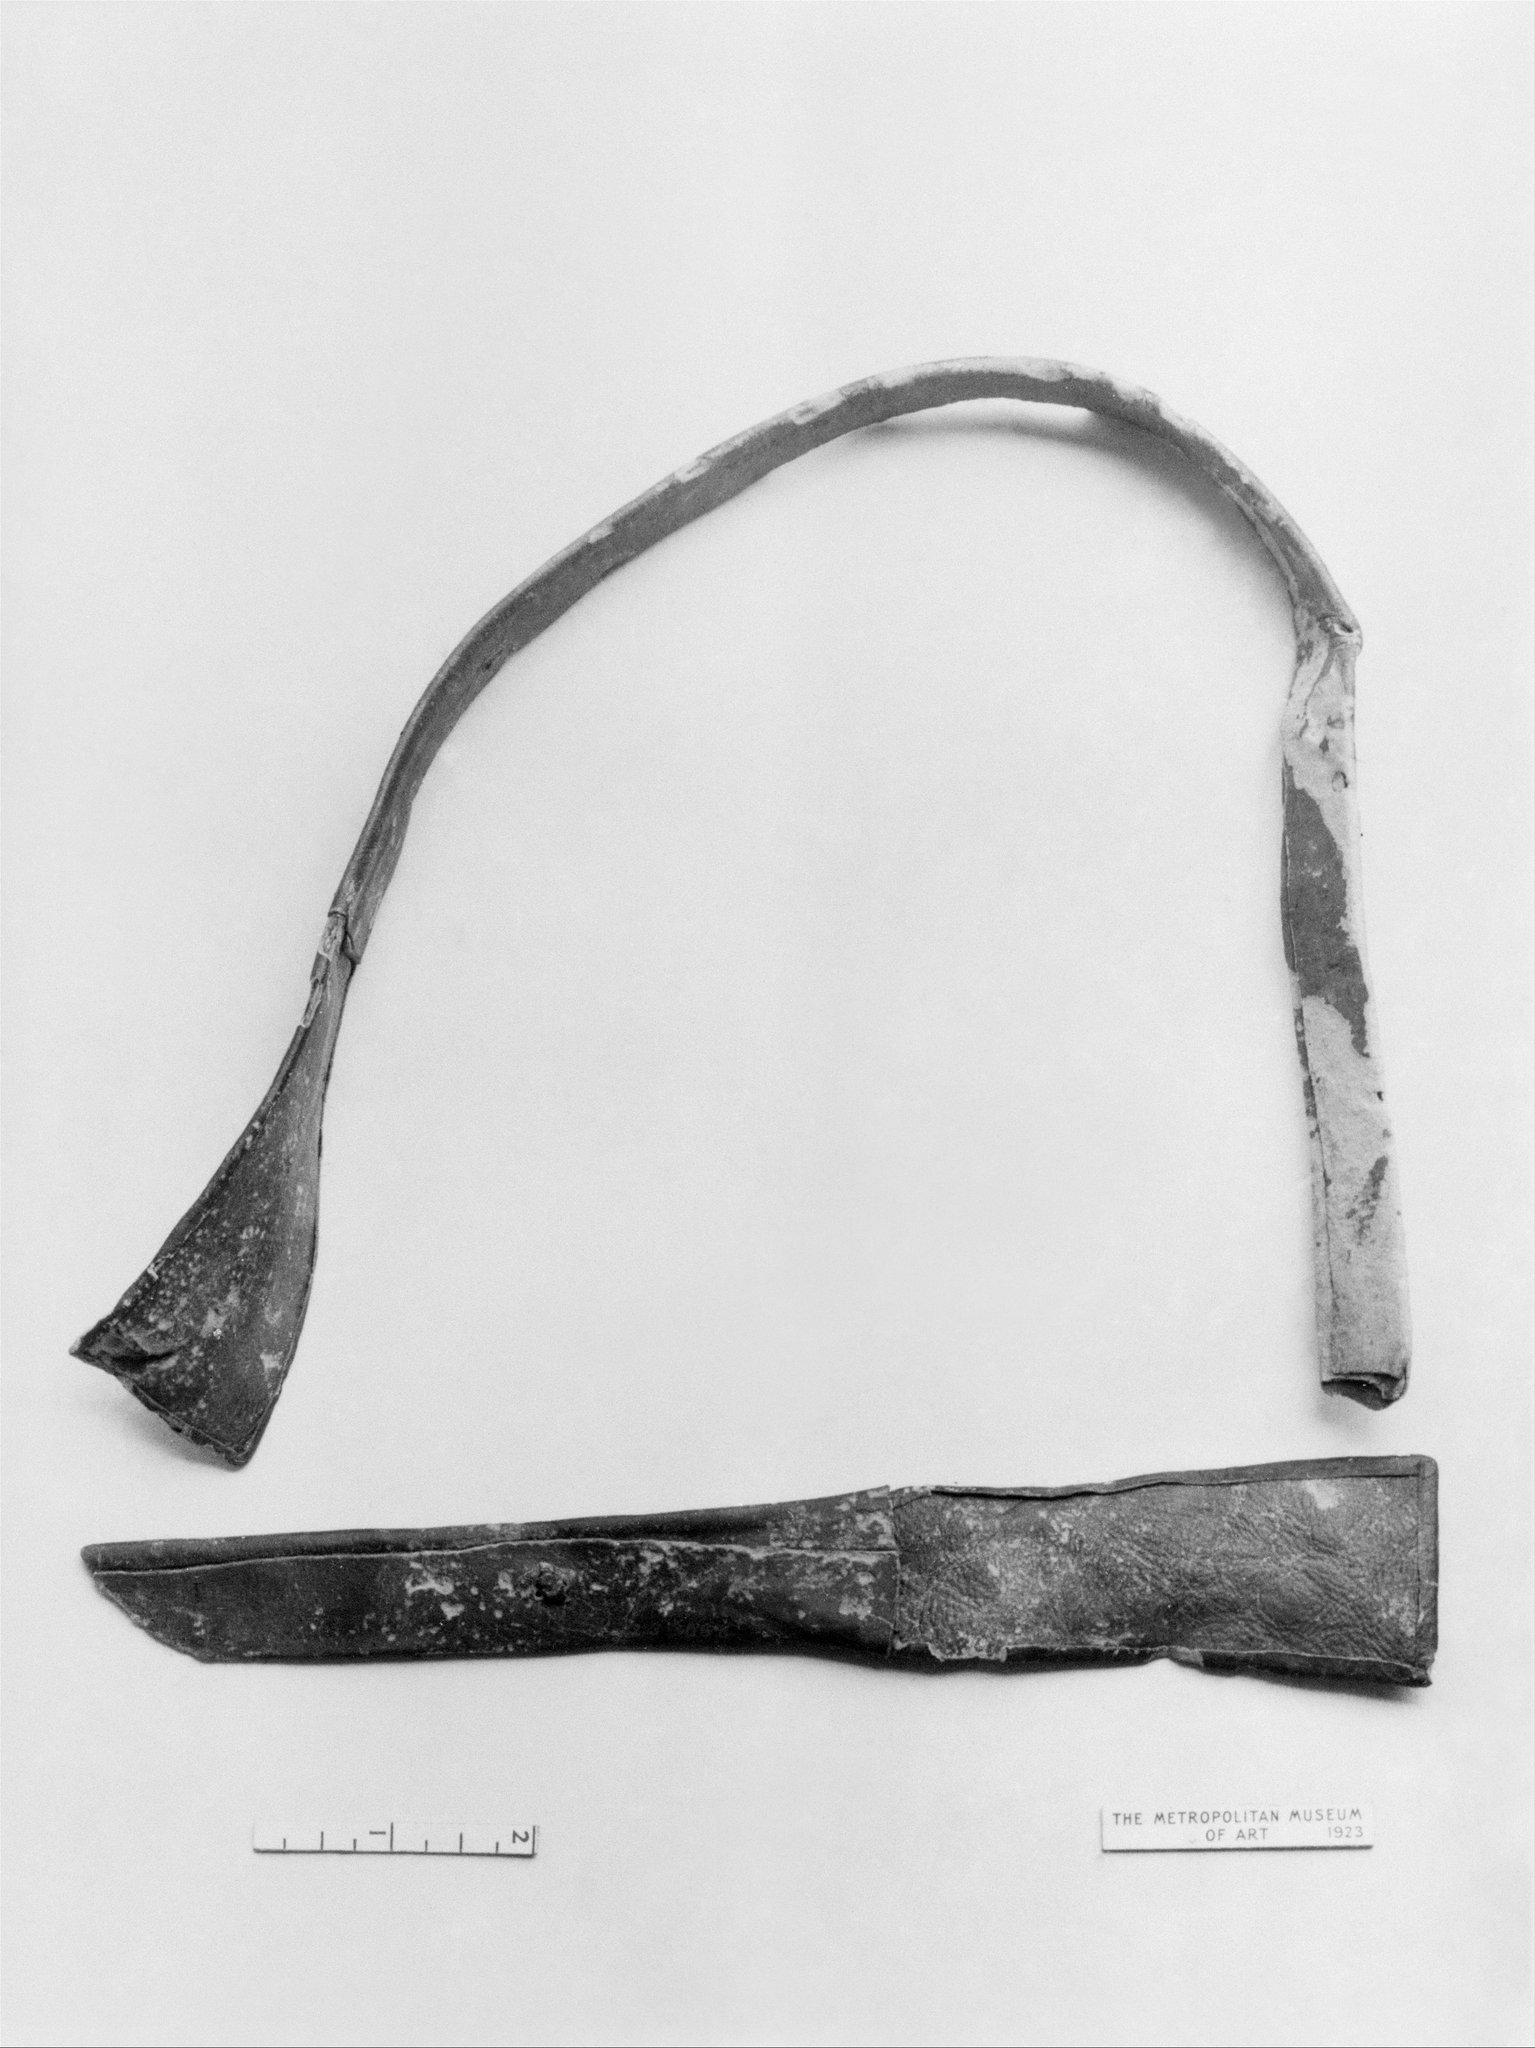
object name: mummy brace, painedjem, menkheperre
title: Mummy braces bearing the name of Painedjem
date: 1070-889 BCE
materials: dye, leather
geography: egypt